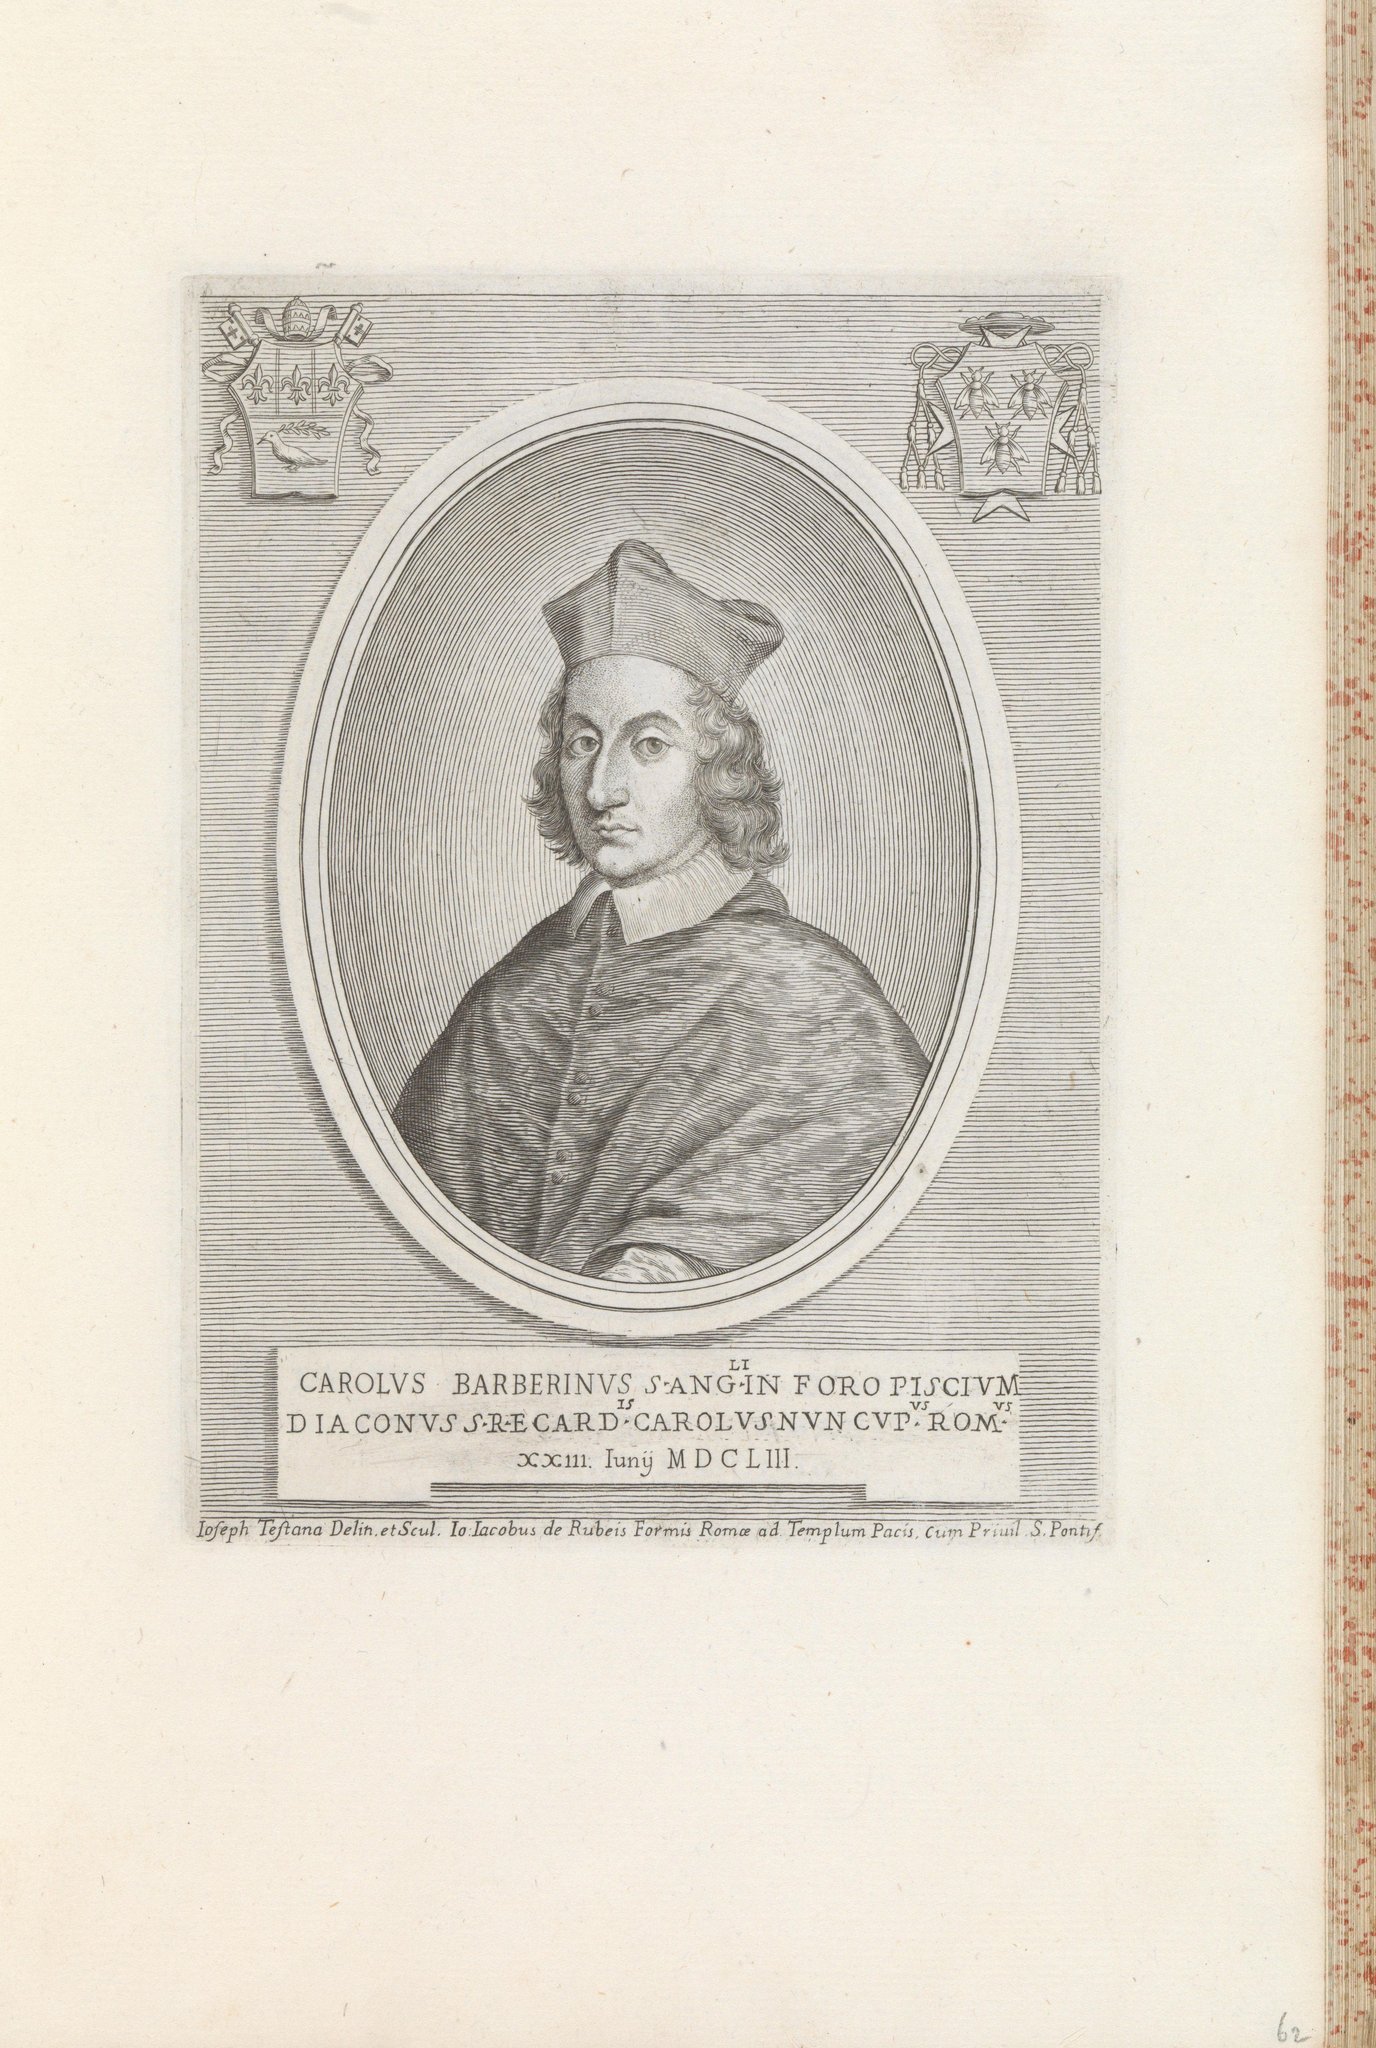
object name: print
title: Portret van kardinaal Carlo Barberini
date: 1658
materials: paper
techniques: engraving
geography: rome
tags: rome, cardinal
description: Portret van kardinaal Carlo Barberini. Linksboven het wapen van paus Innocentius X en rechtsboven het wapen van de kardinaal. Onderaan een onderschrift in het Latijn. De prent maakt deel uit van een album.